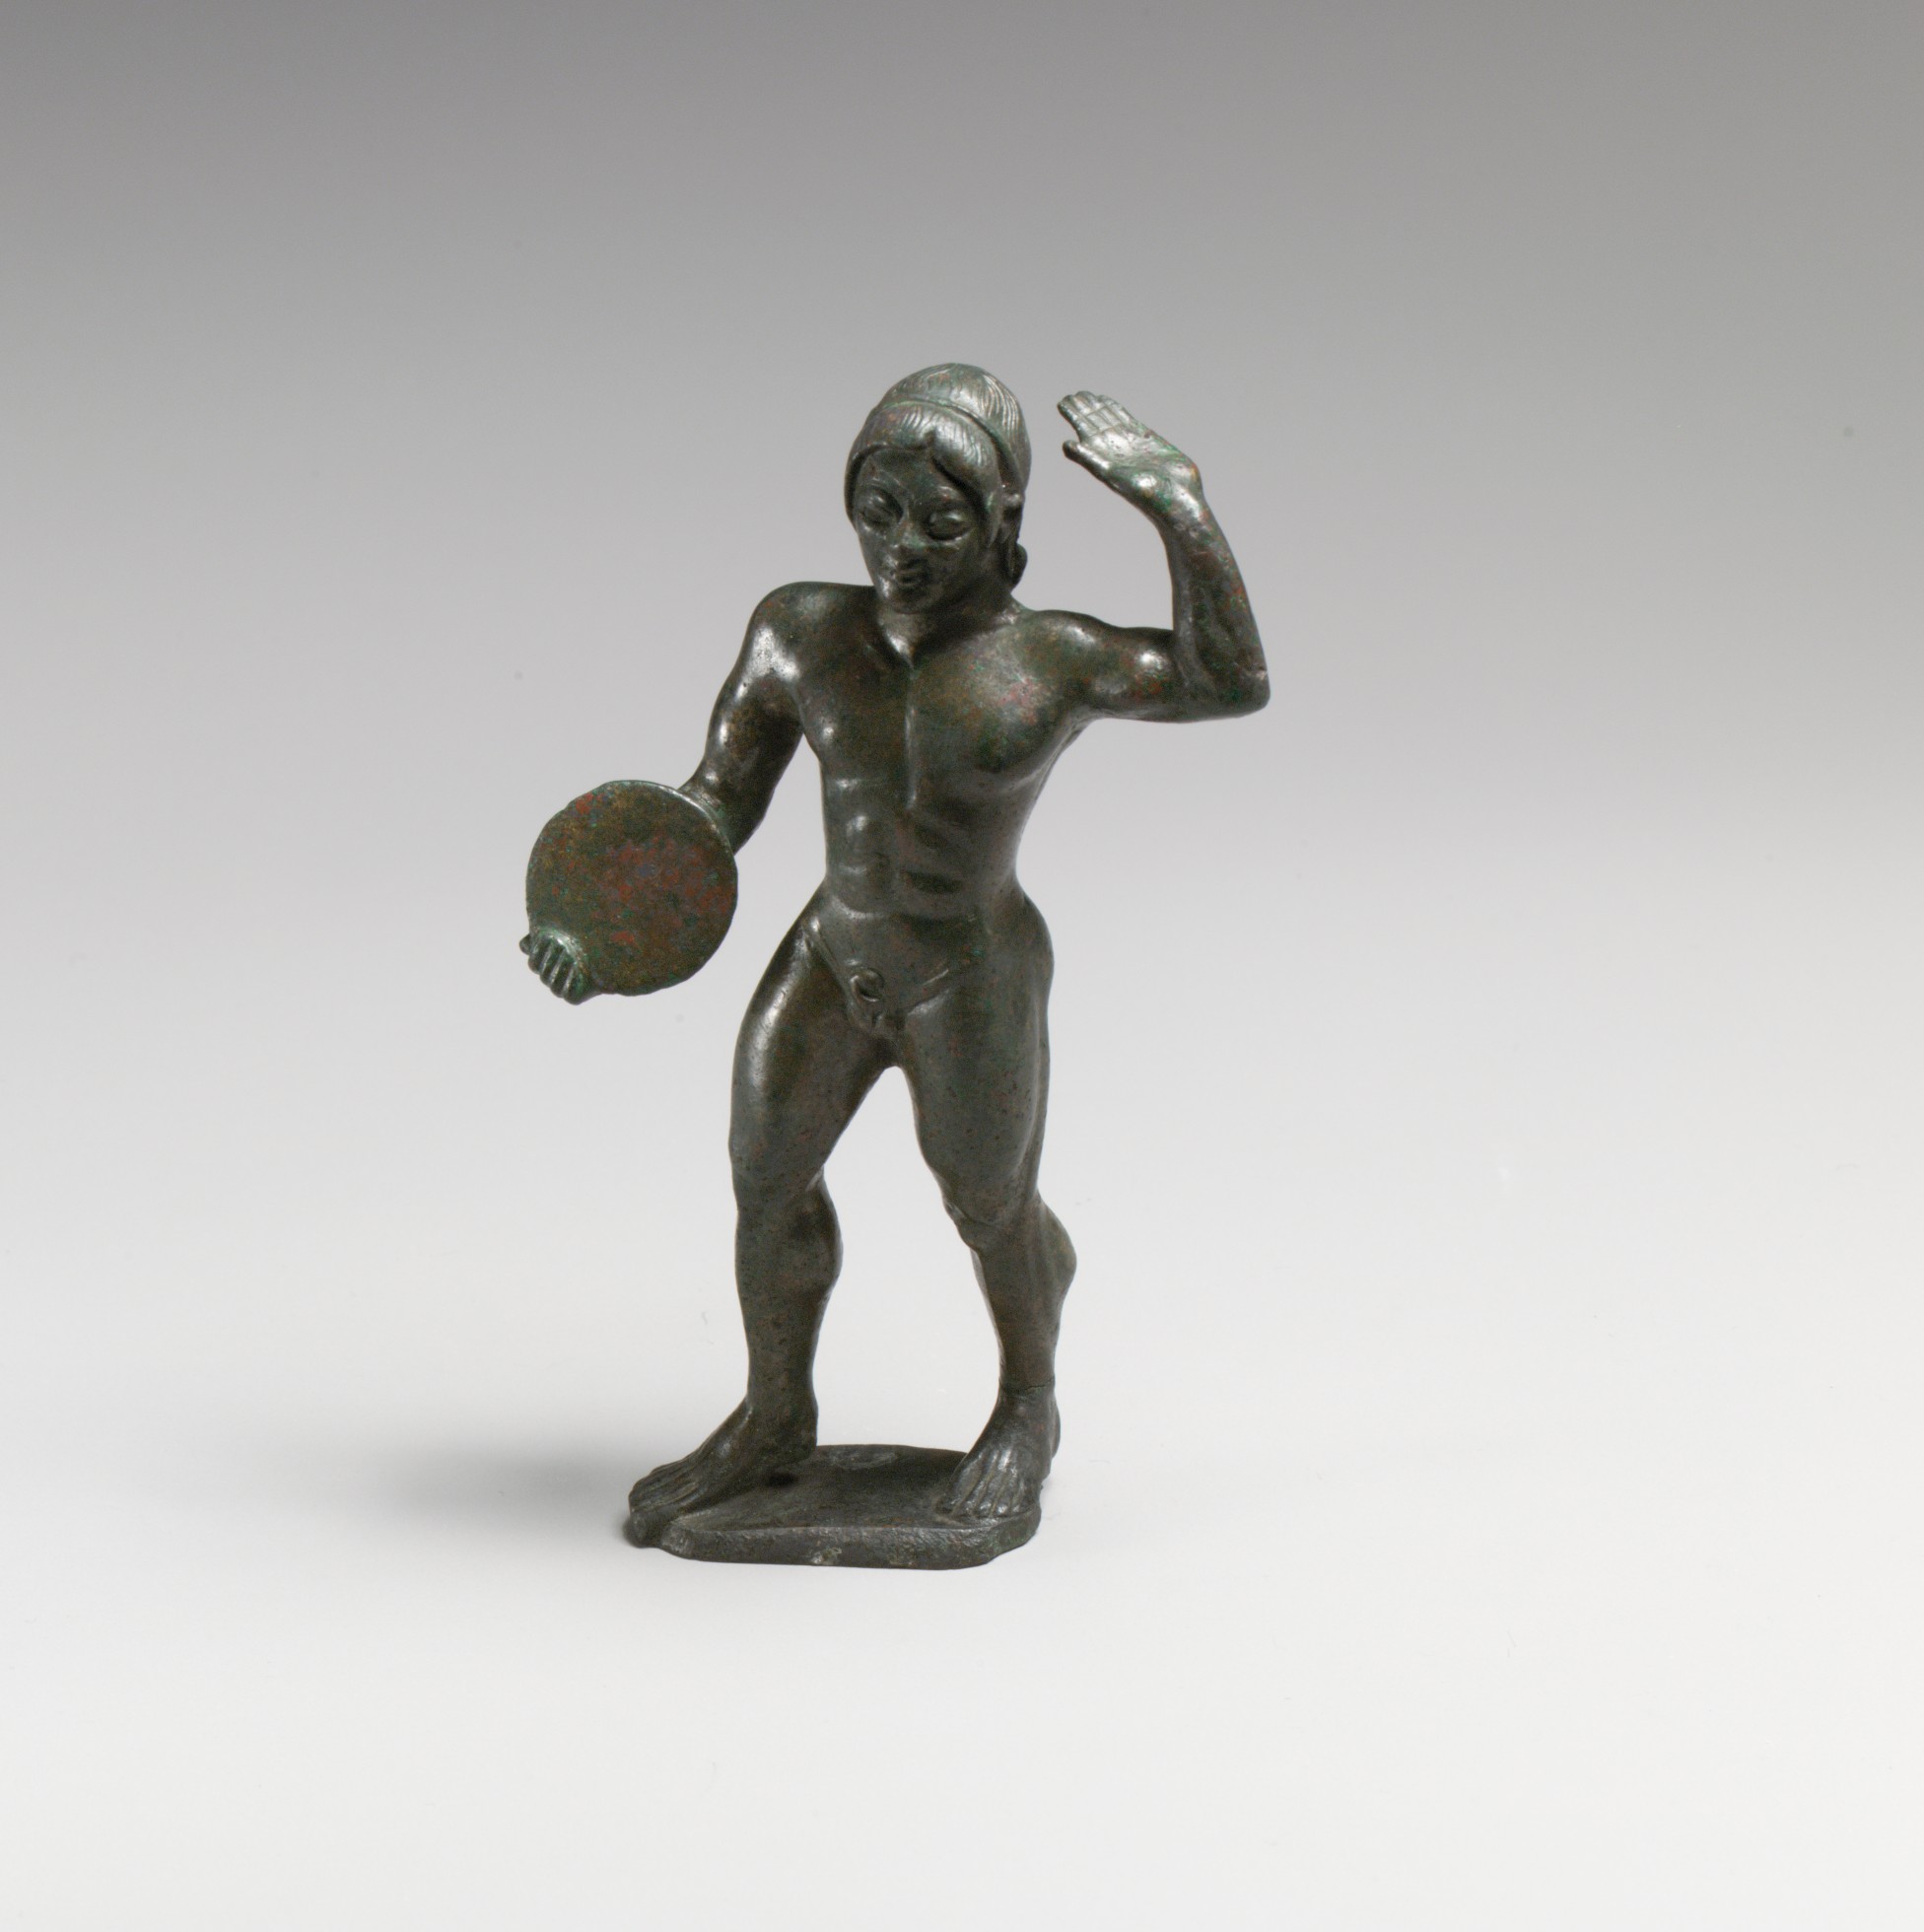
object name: statuette of a diskos thrower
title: Bronze statuette of a diskos thrower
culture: etruscan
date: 500-475 BCE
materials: bronze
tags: male nudes,athletes